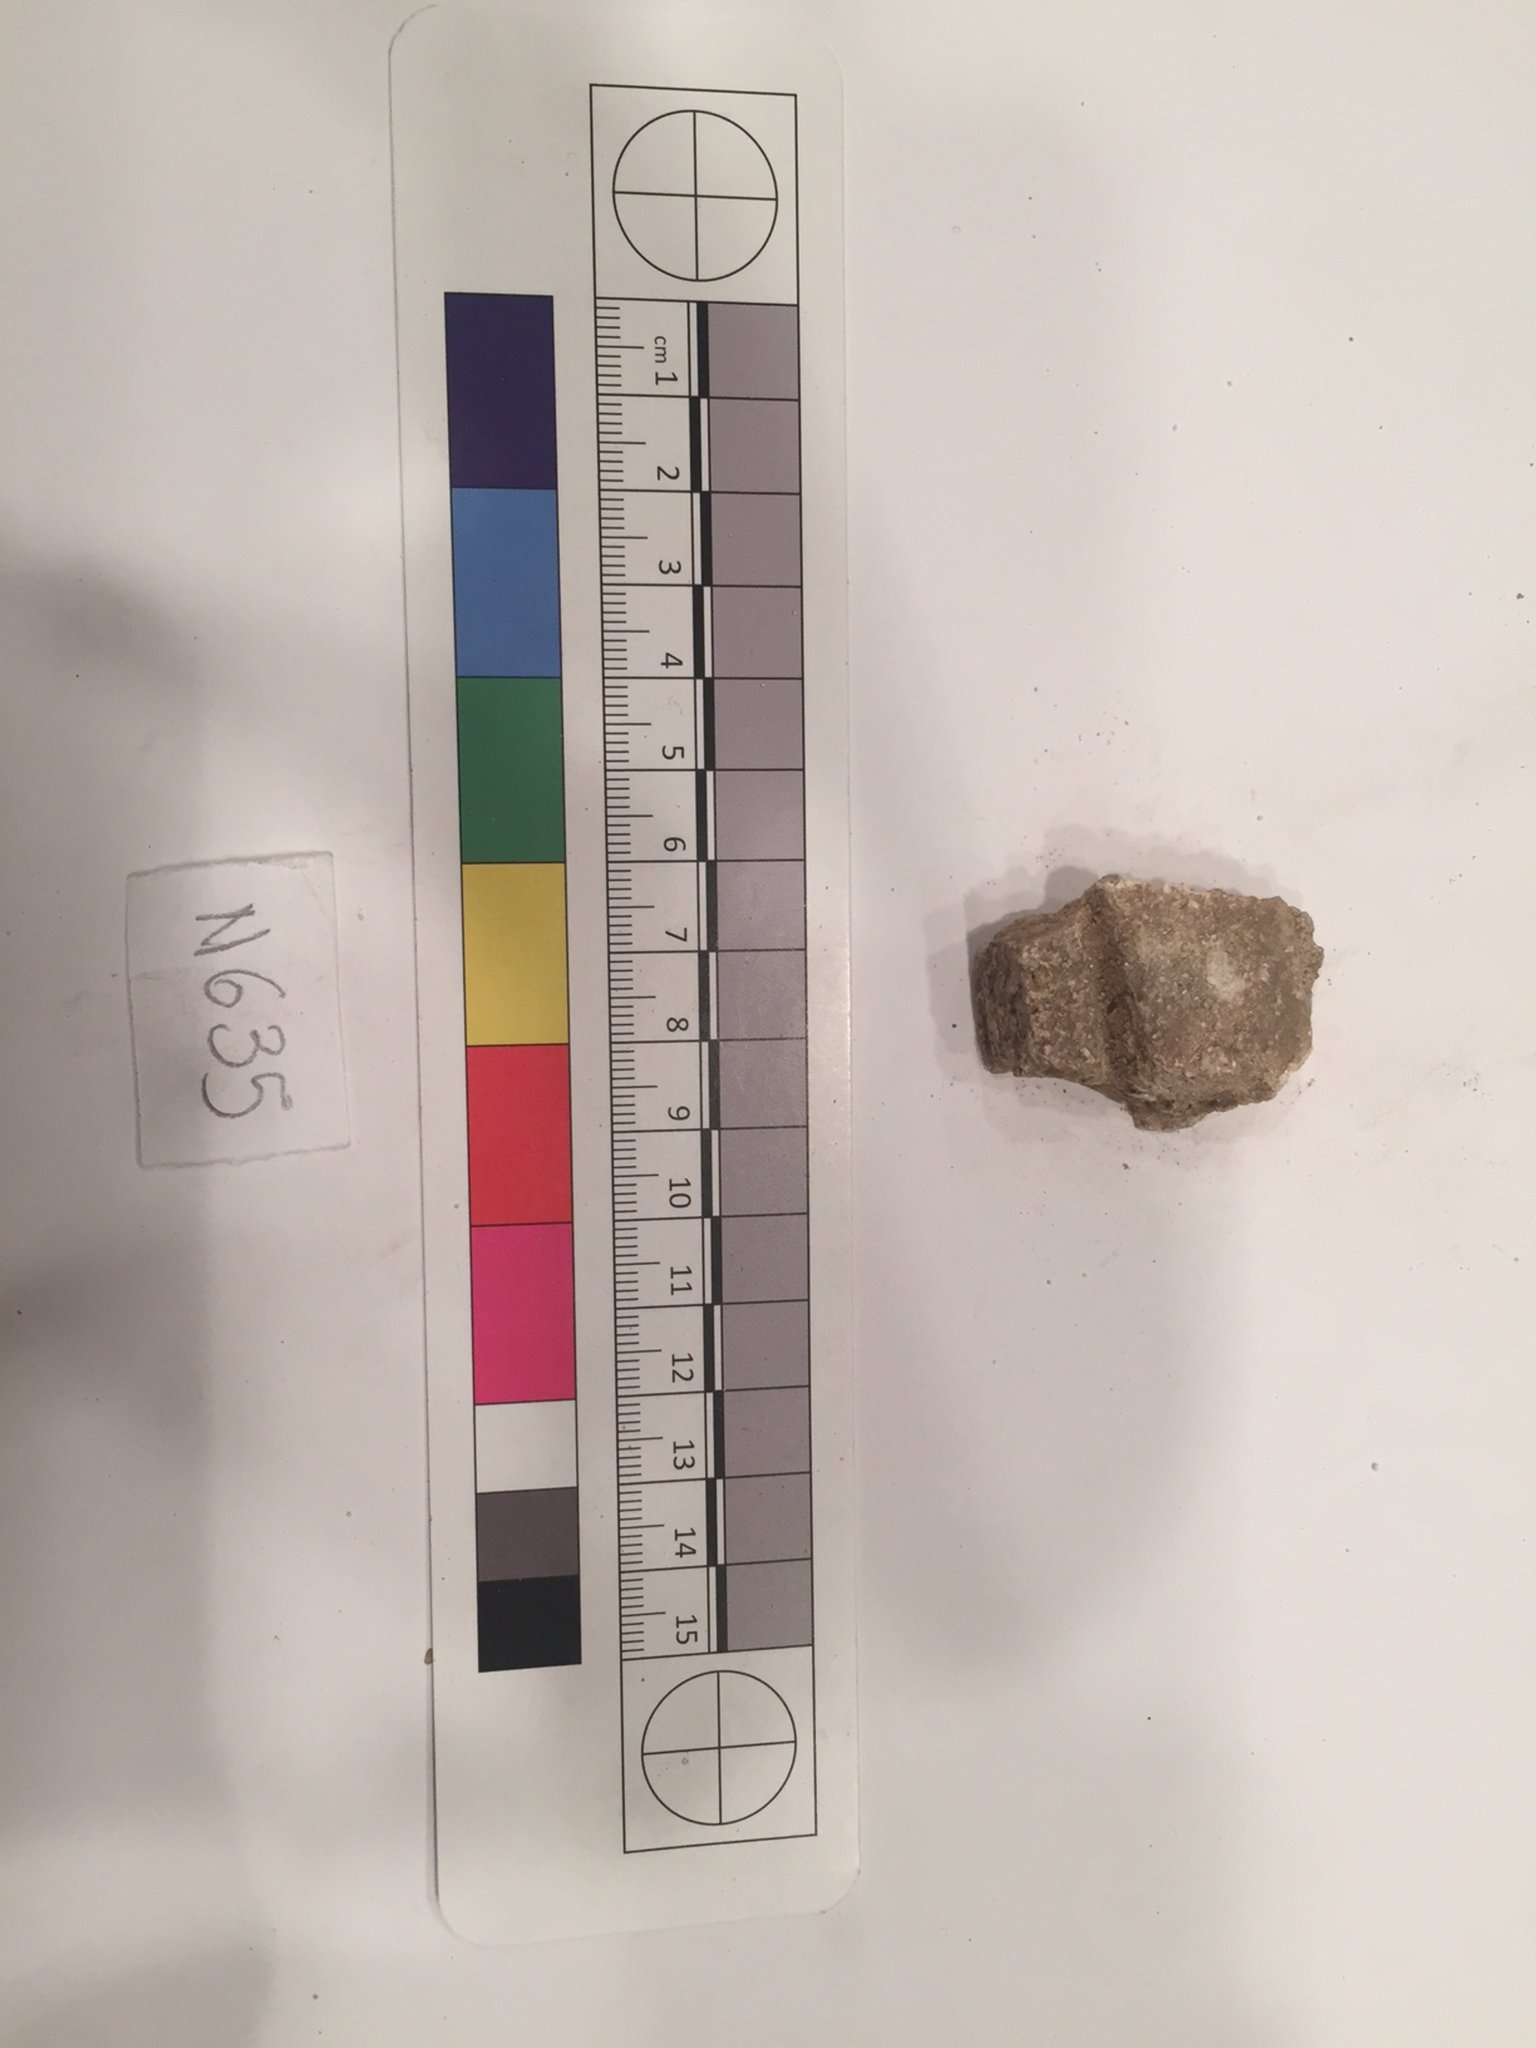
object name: fragment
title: Stucco Fragment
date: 701-1200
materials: plaster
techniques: carving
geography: iran